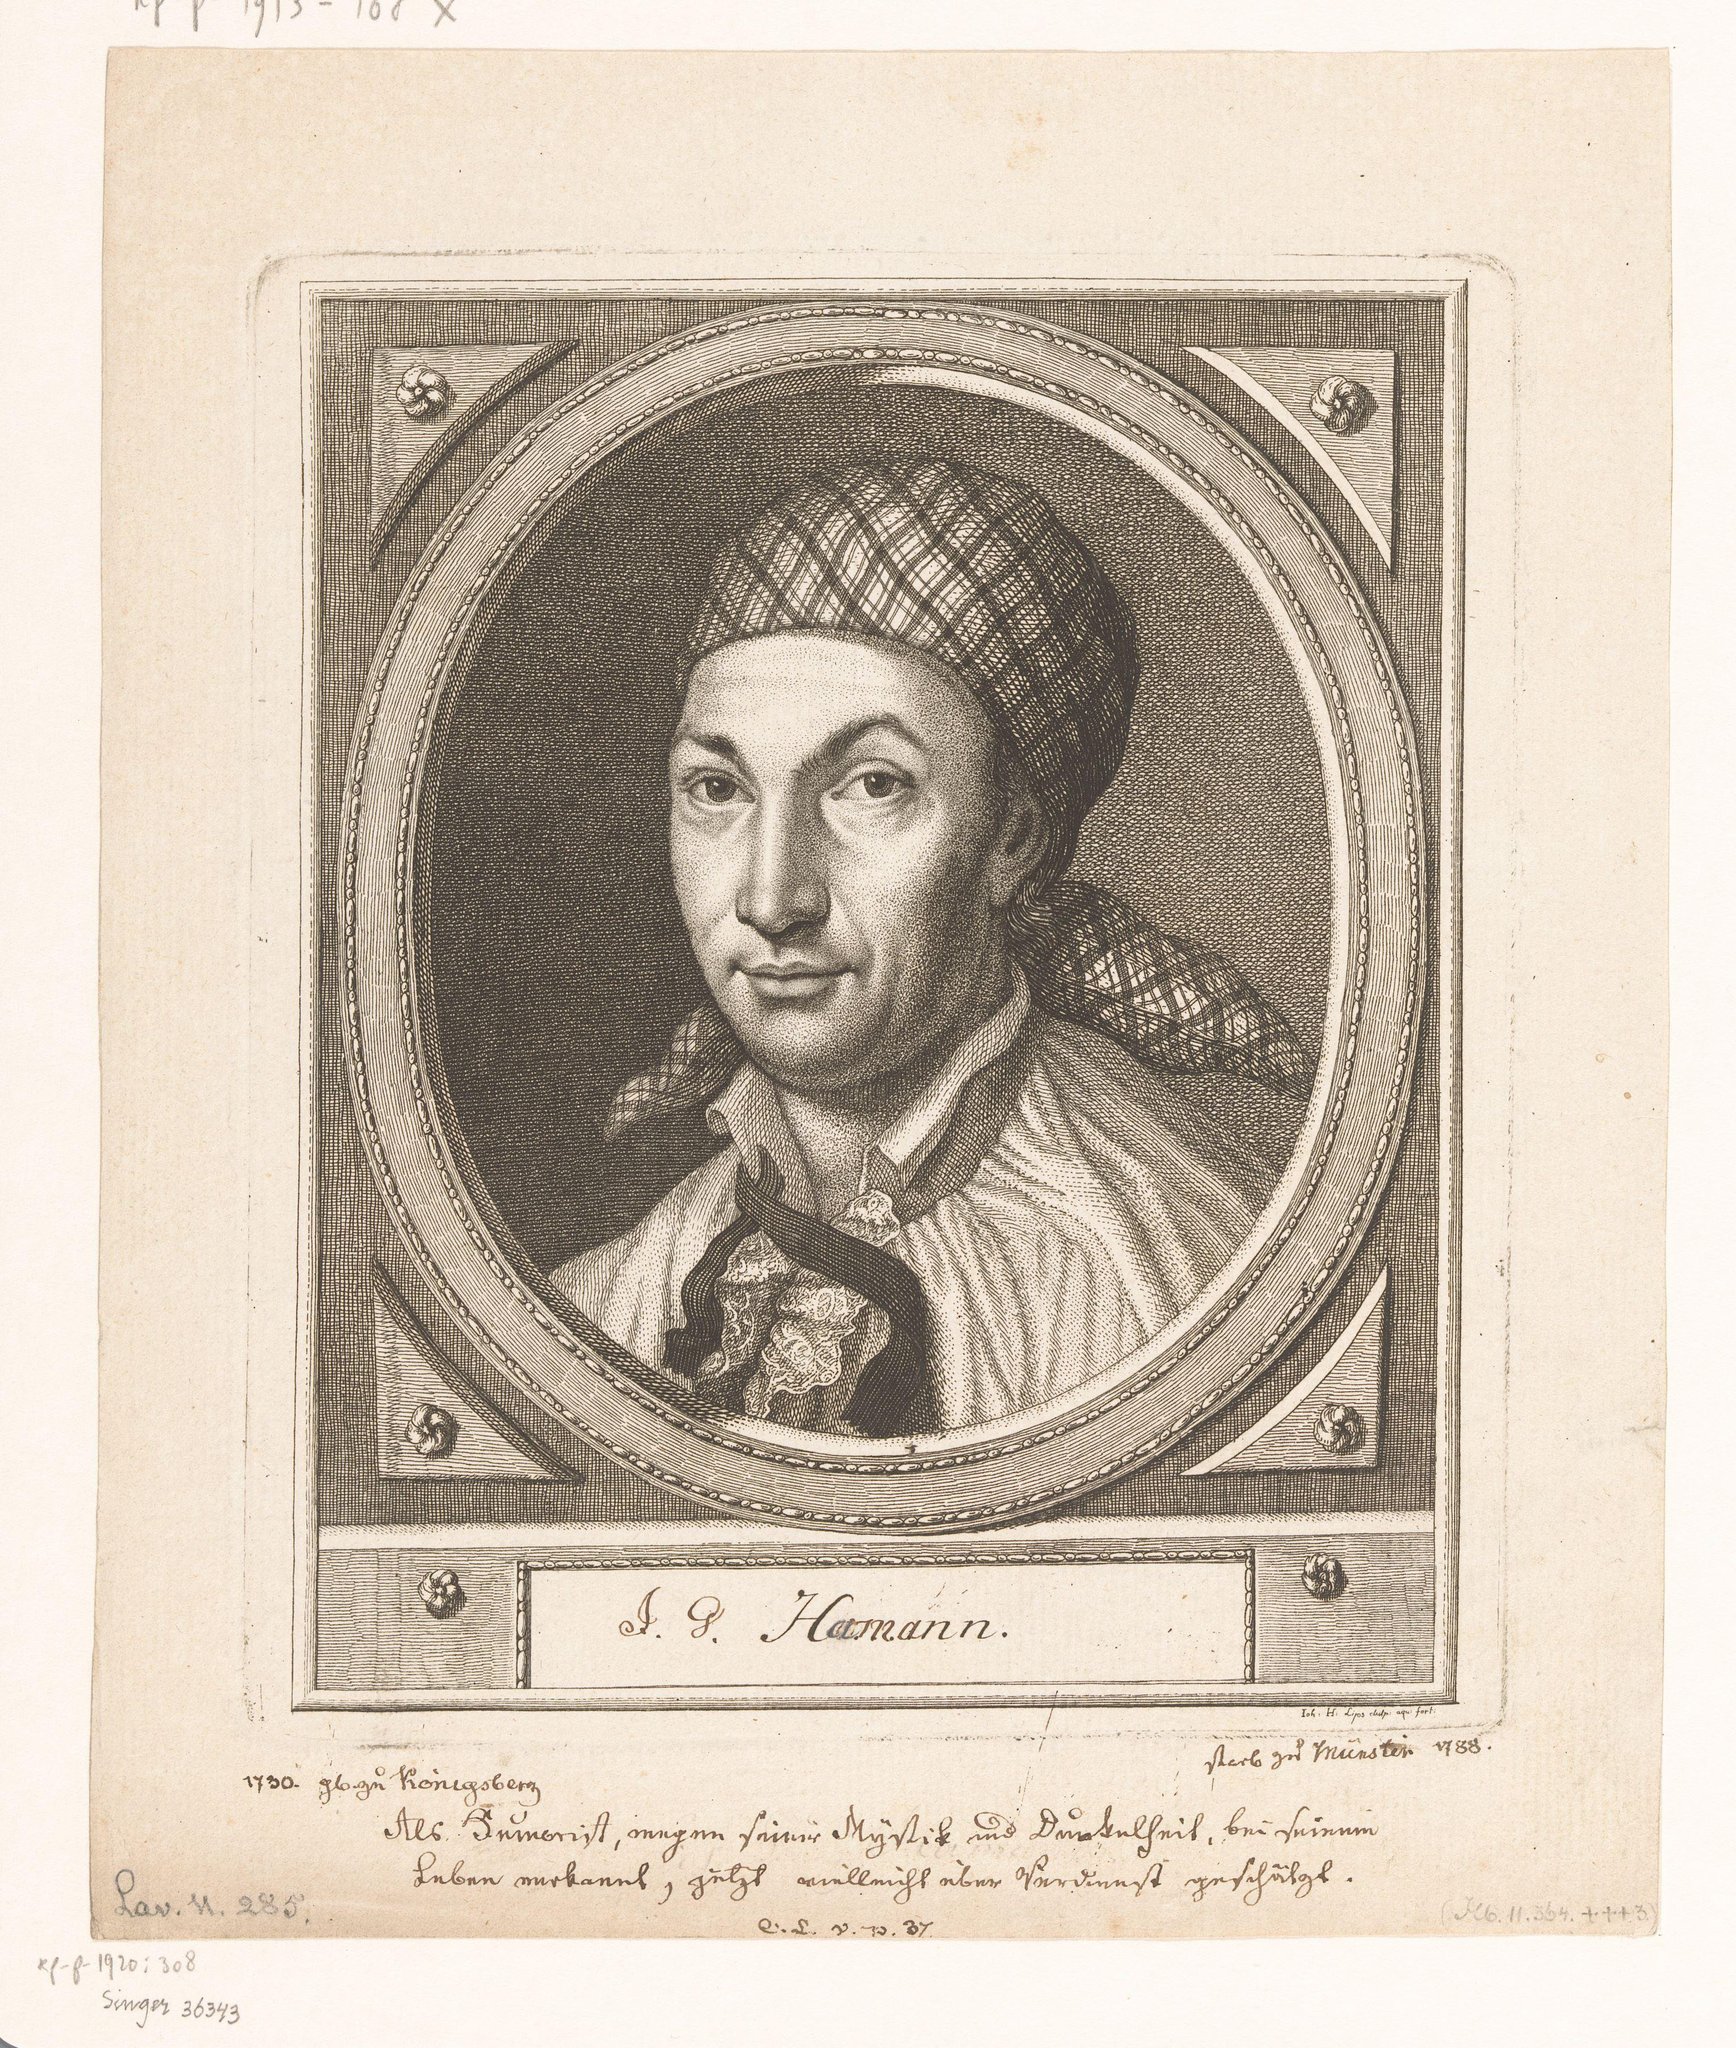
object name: print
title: Portret van Johann Georg Hamann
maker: johann heinrich lips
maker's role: draughtsman, painter, print maker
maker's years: 1758-1817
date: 1768-1817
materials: paper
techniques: etching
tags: historical persons, portrait of a writer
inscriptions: collector's mark: Lugt 2228, name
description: Alleen de letters "H nn" zijn gedrukt, de rest is ingevuld met de hand in bruine inkt.